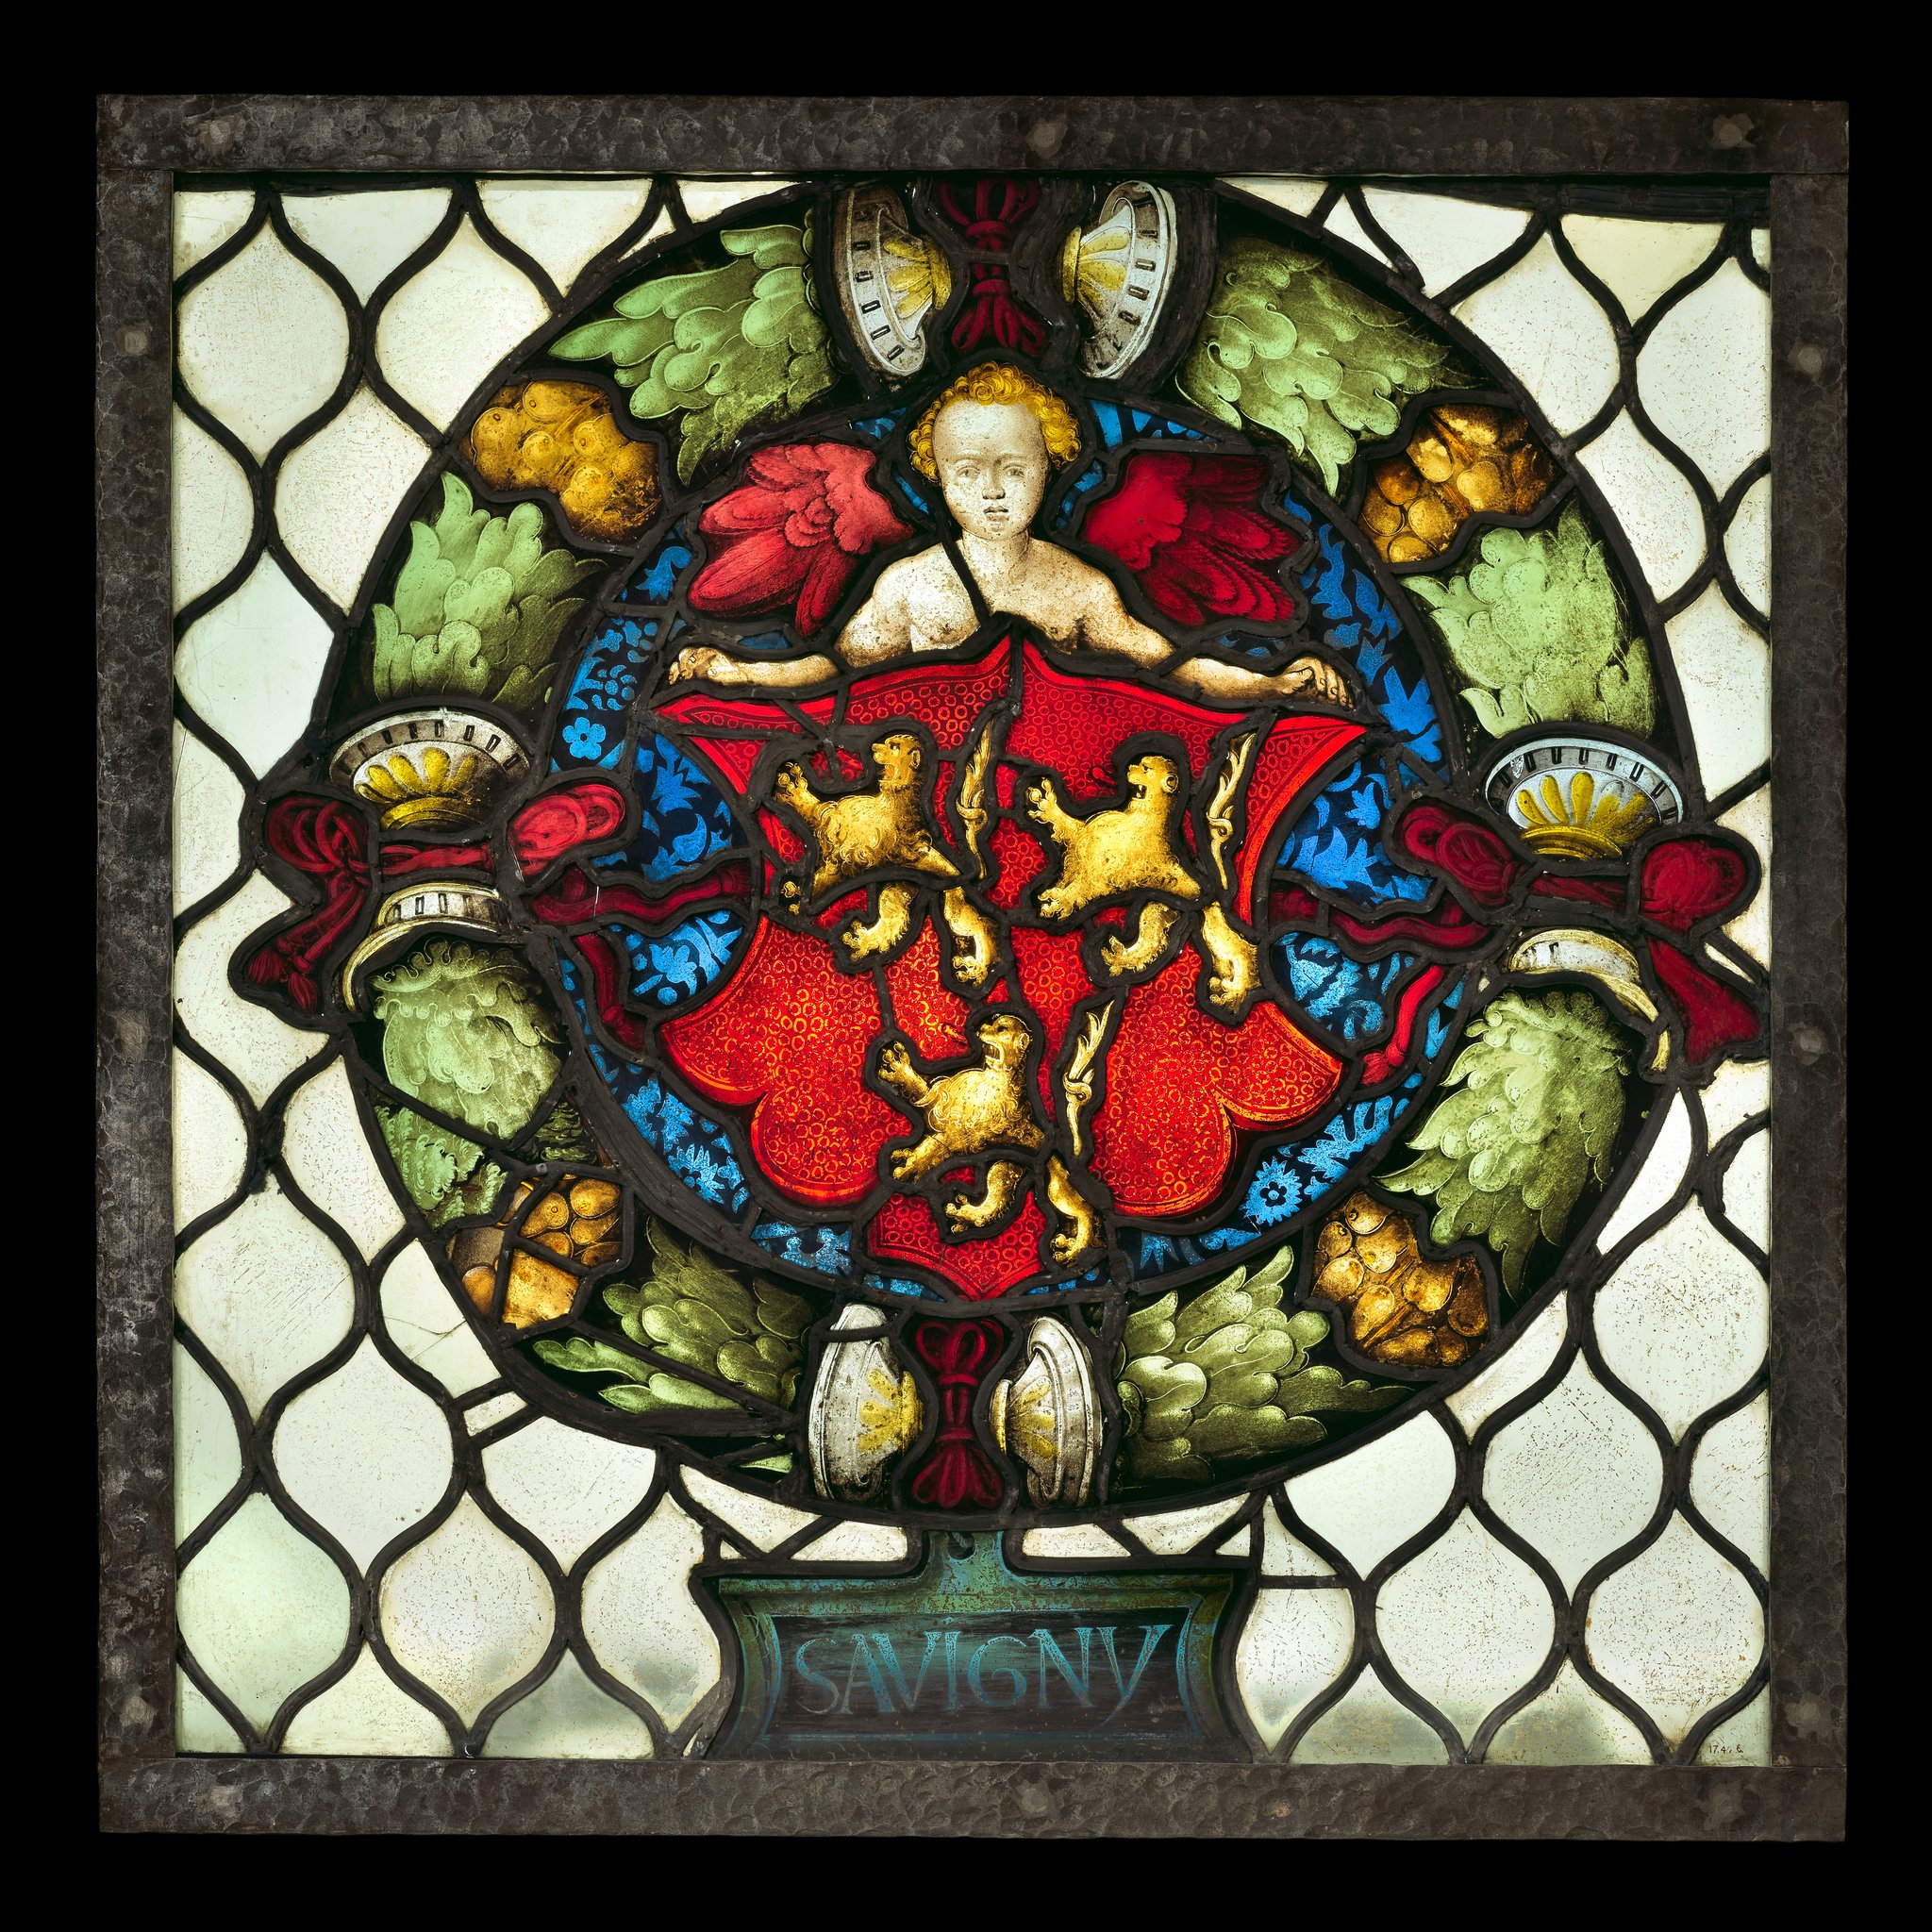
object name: armorial medallion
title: The Savigny Arms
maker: valentin bousch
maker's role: artist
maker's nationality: french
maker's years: 1514-1541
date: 1533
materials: glass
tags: lions,coat of arms